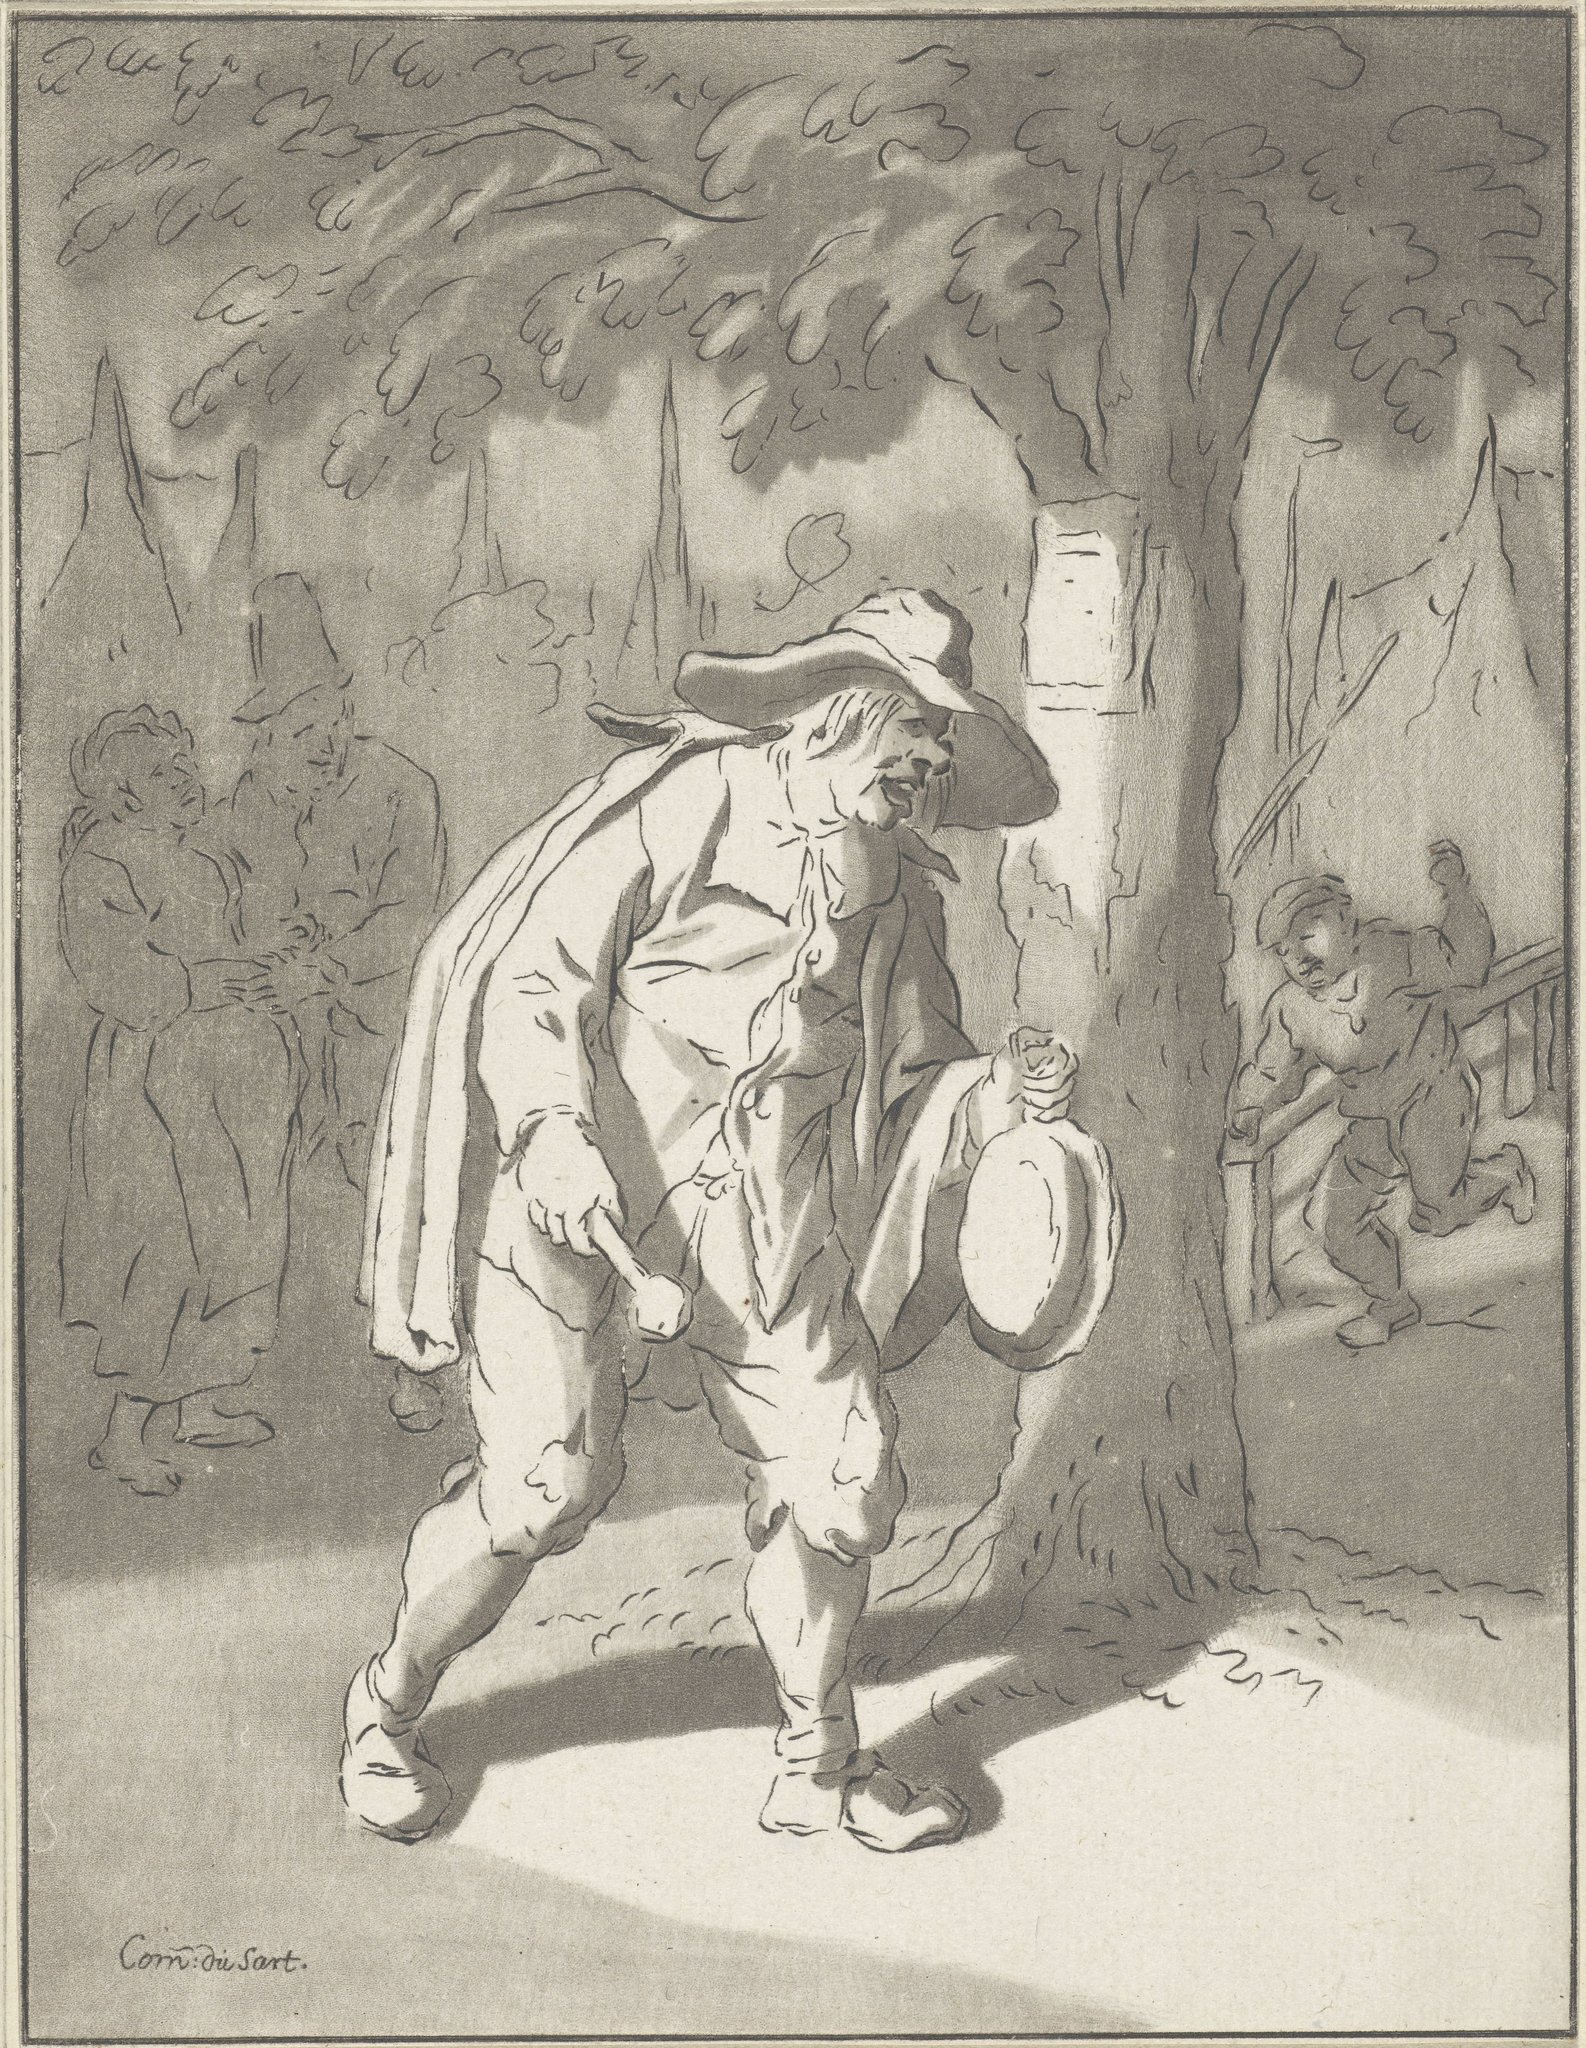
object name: print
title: Omroeper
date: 1776-1777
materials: paper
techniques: etching, roulette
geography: amsterdam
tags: oral spreading of news, town crier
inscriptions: collector's mark: Lugt 1702, collector's mark: Lugt 2228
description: Een stadsomroeper met slagwerk bij een boom. Op de achtergrond luisterende mensen.